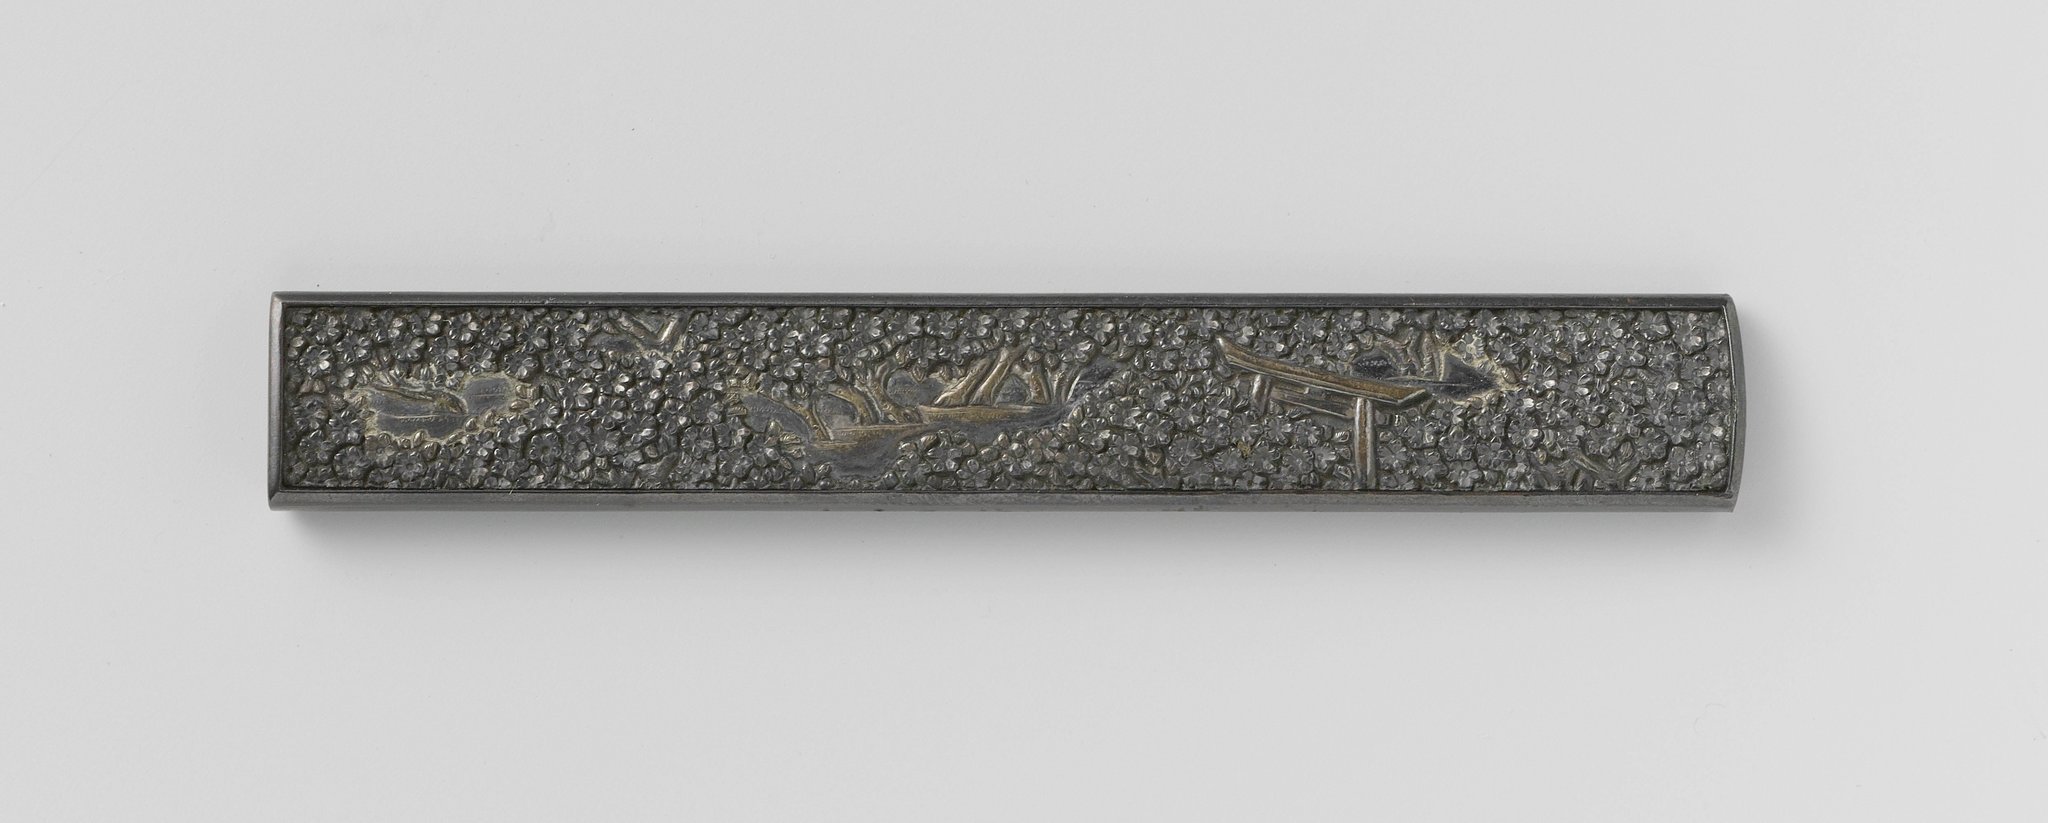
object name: zwaardmesheft, kozuka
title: Sword knife hilt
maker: Anonymous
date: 1500-1900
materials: gold, iron, silver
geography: japan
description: Versierd met een torii verscholen achter gebladerte en chrysanten.